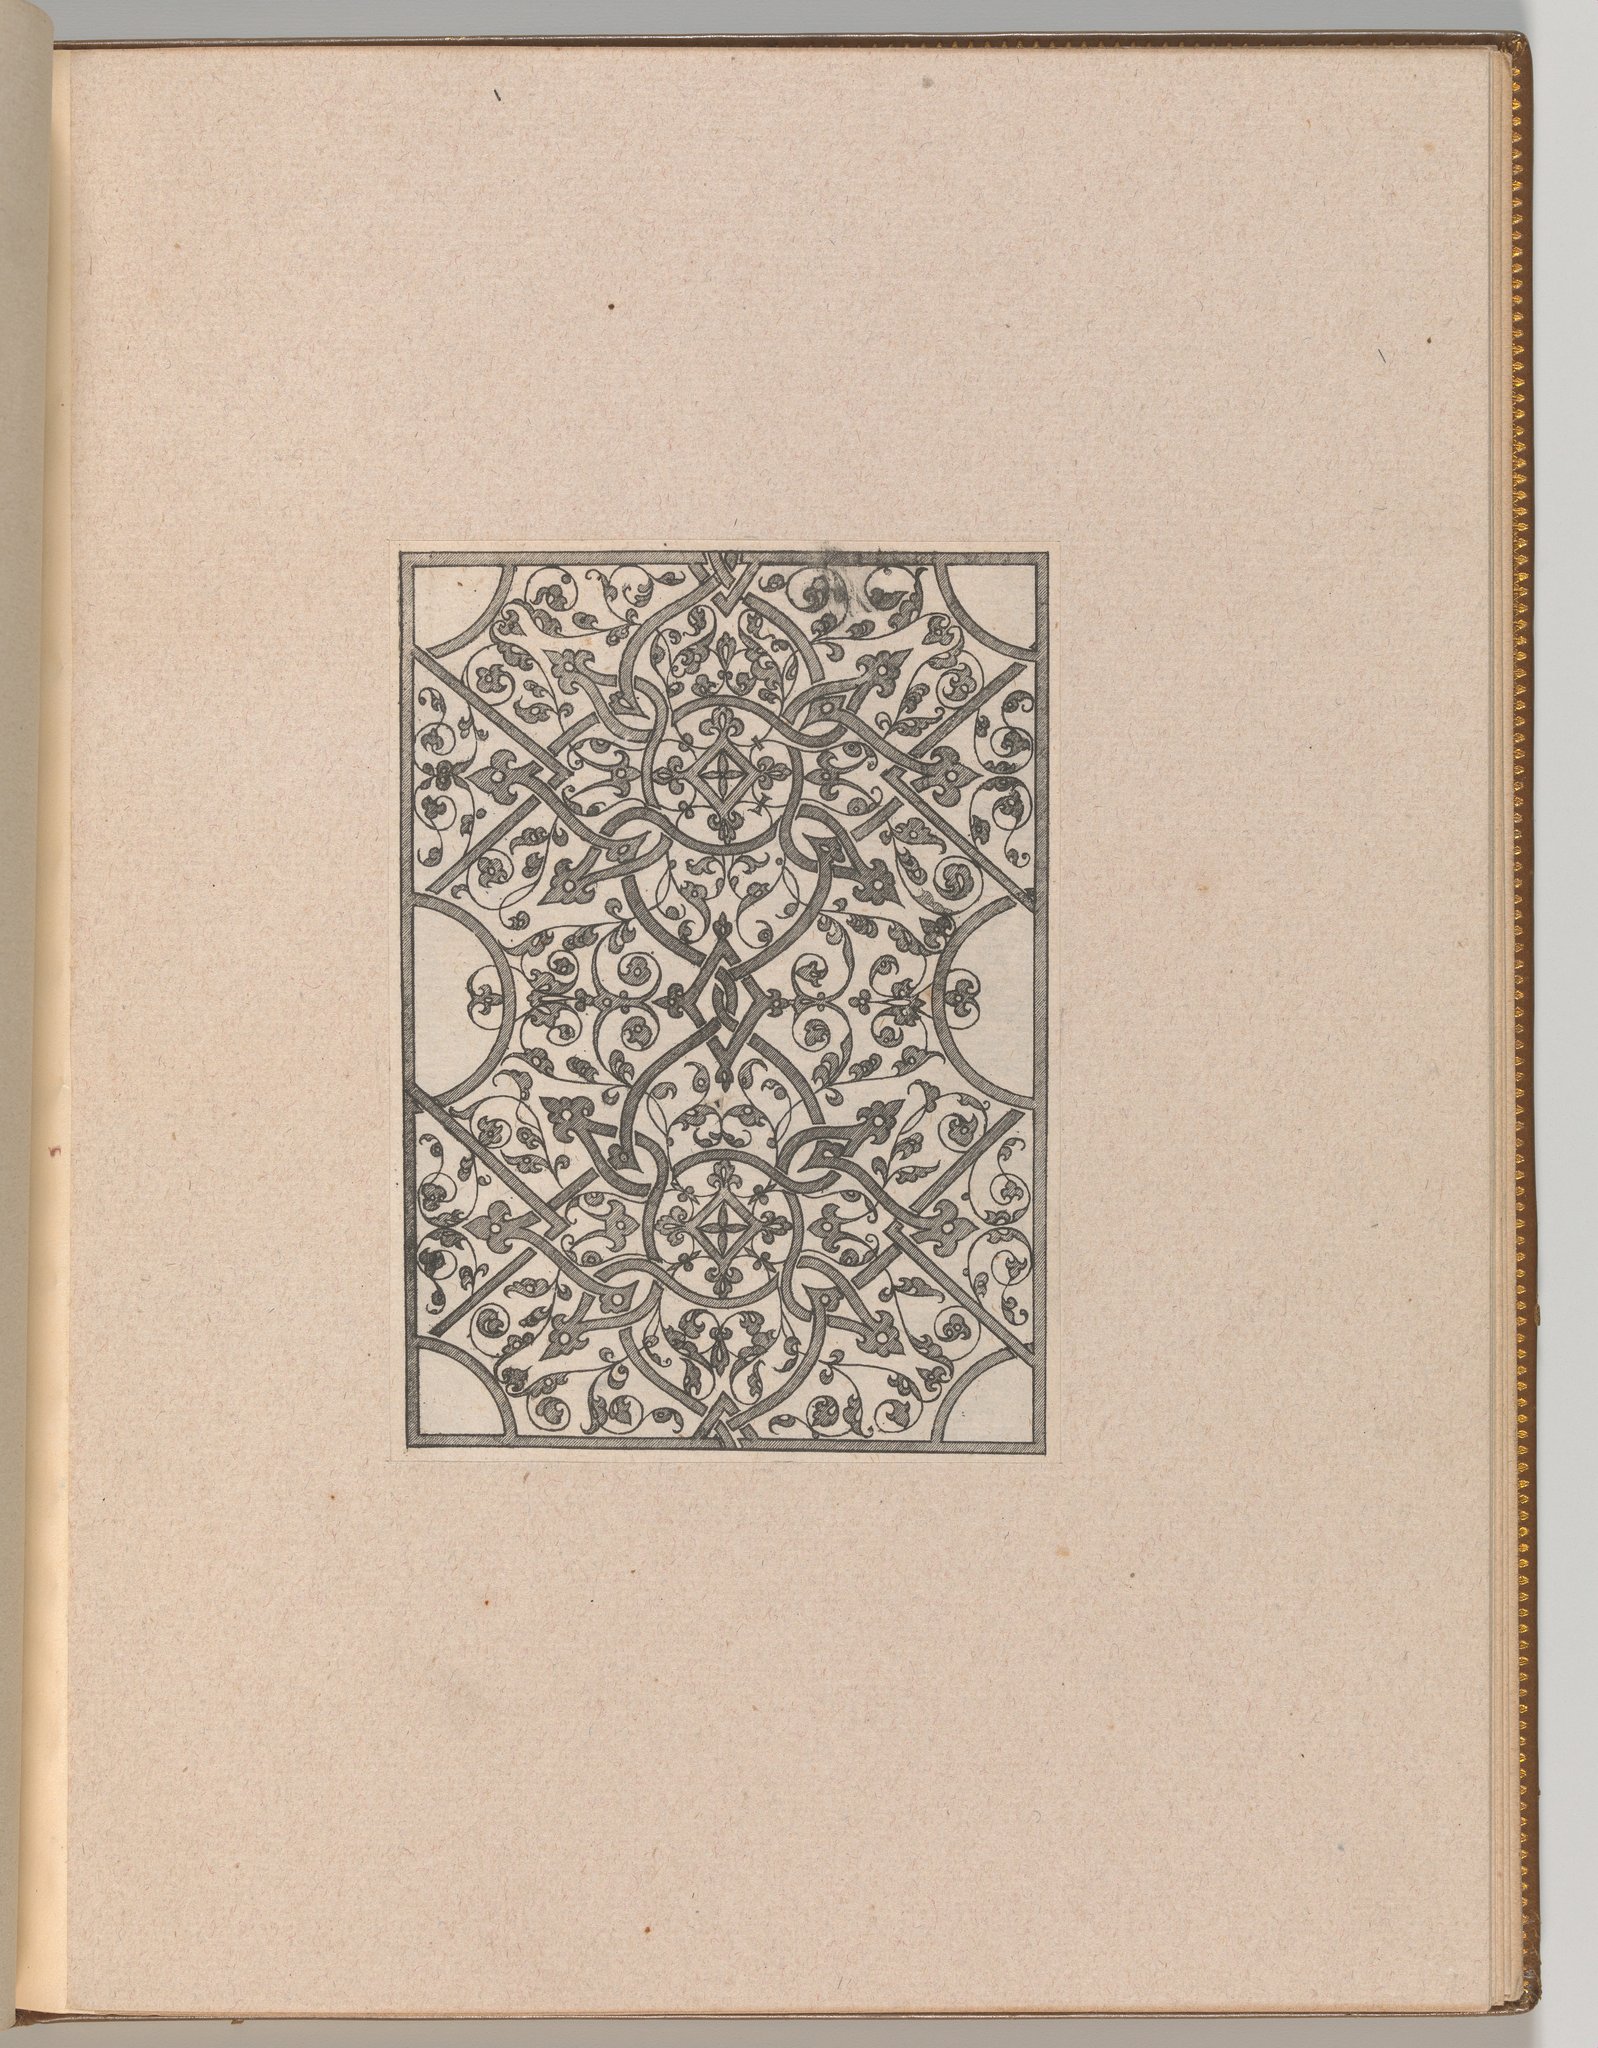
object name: album print ornament architecture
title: Copies after the 'Livre contenant passement de moresques'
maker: jacques androuet du cerceau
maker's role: artist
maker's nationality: french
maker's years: 1510-1585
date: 1801-1900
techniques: etching